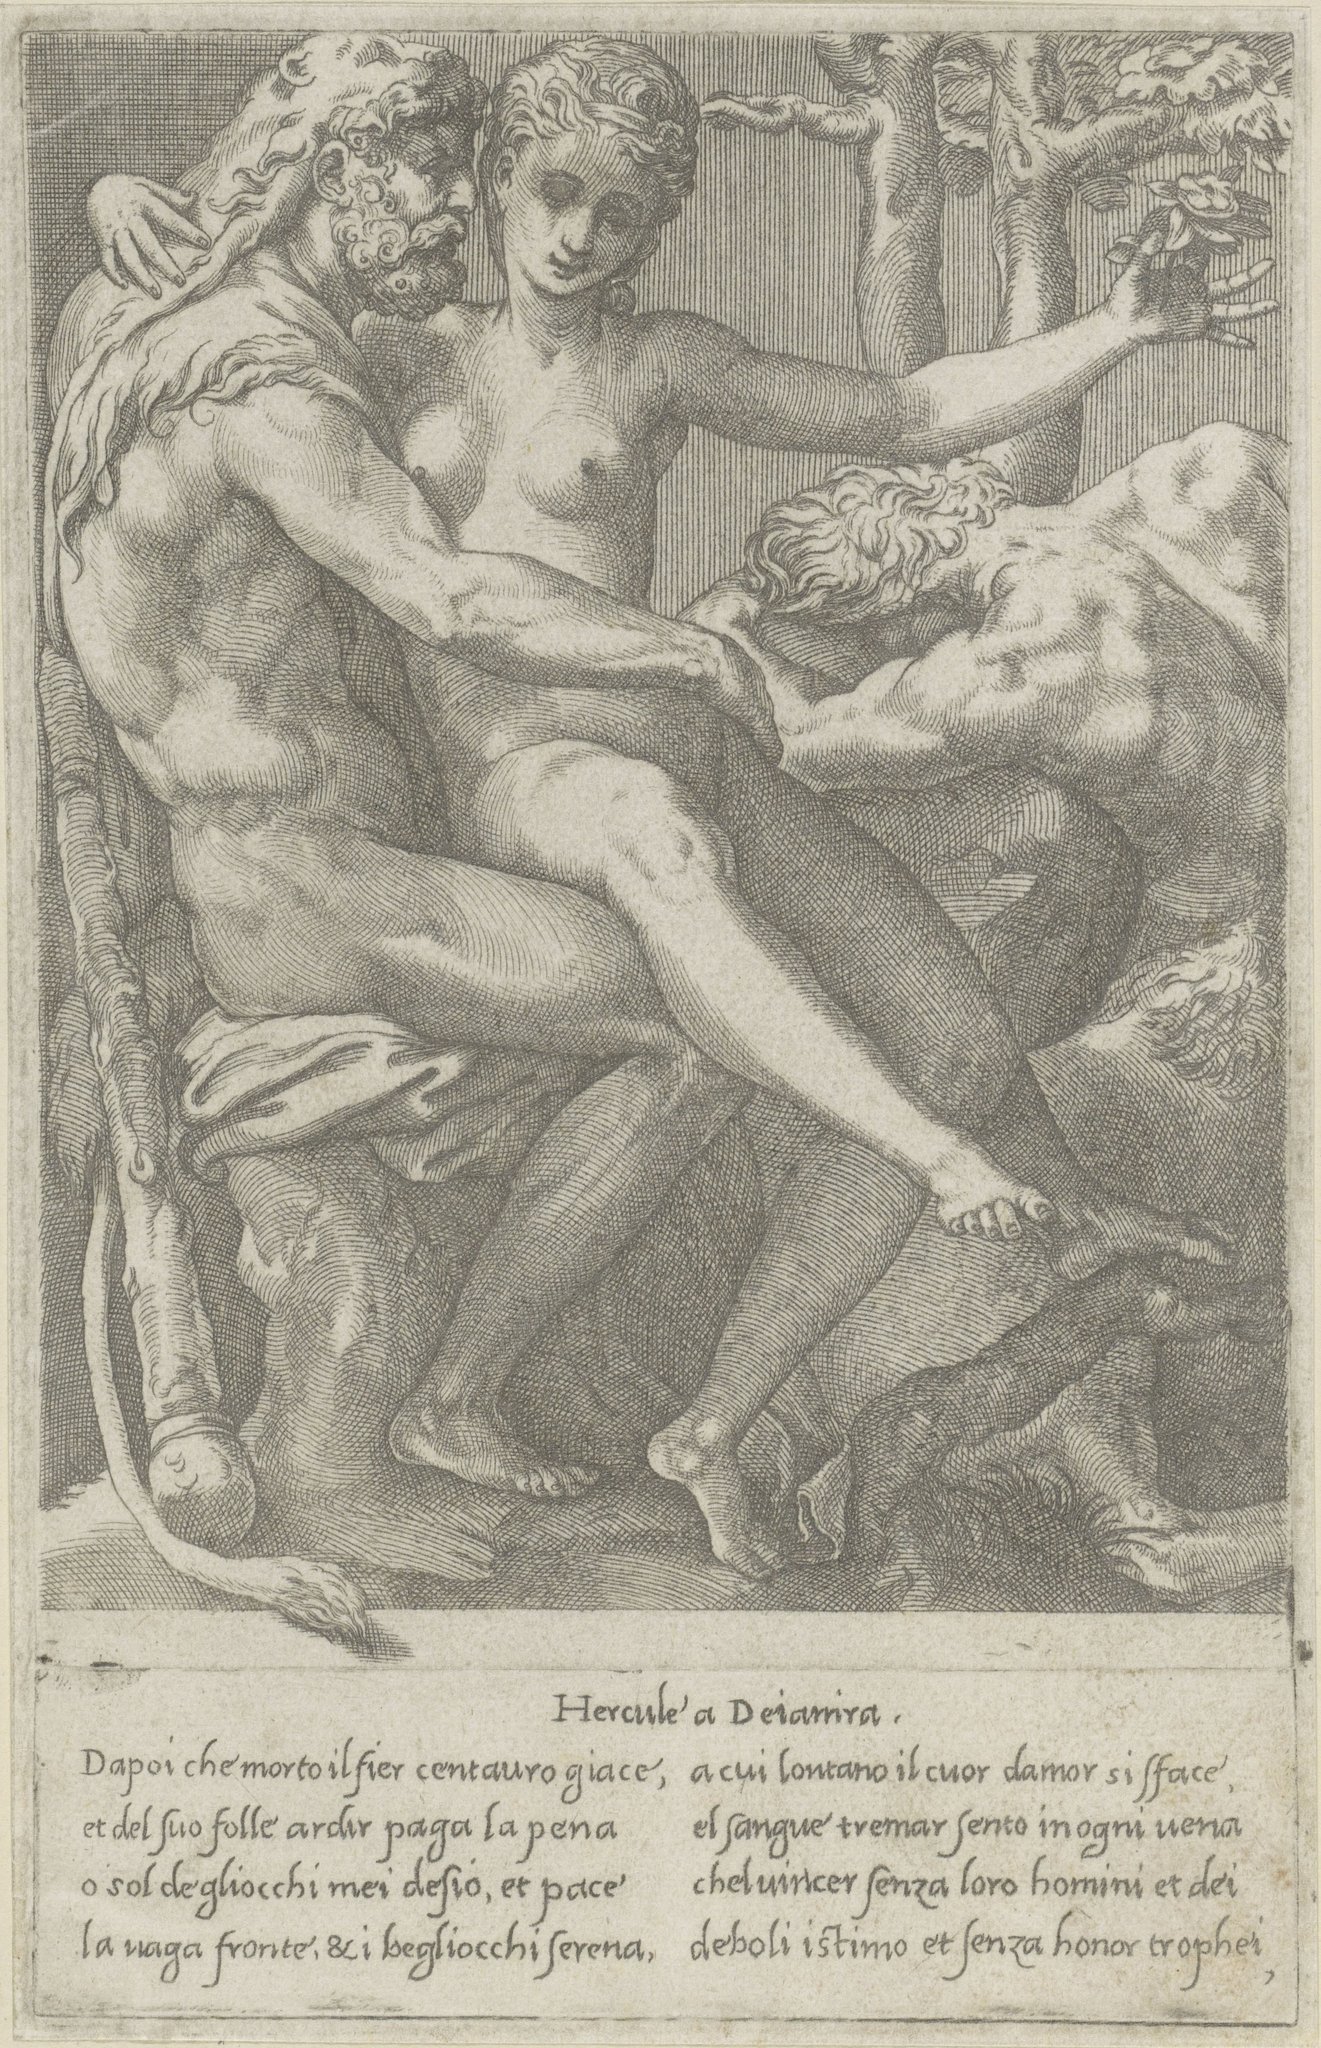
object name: print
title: Loves of the Gods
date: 1515-1565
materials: paper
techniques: engraving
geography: italy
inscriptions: collector's mark: Lugt 240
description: De naakte Deïanira zit bij Hercules op schoot. Rechts ligt de dode centaur Nessus. In ondermarge Italiaans vers in twee kolommen.